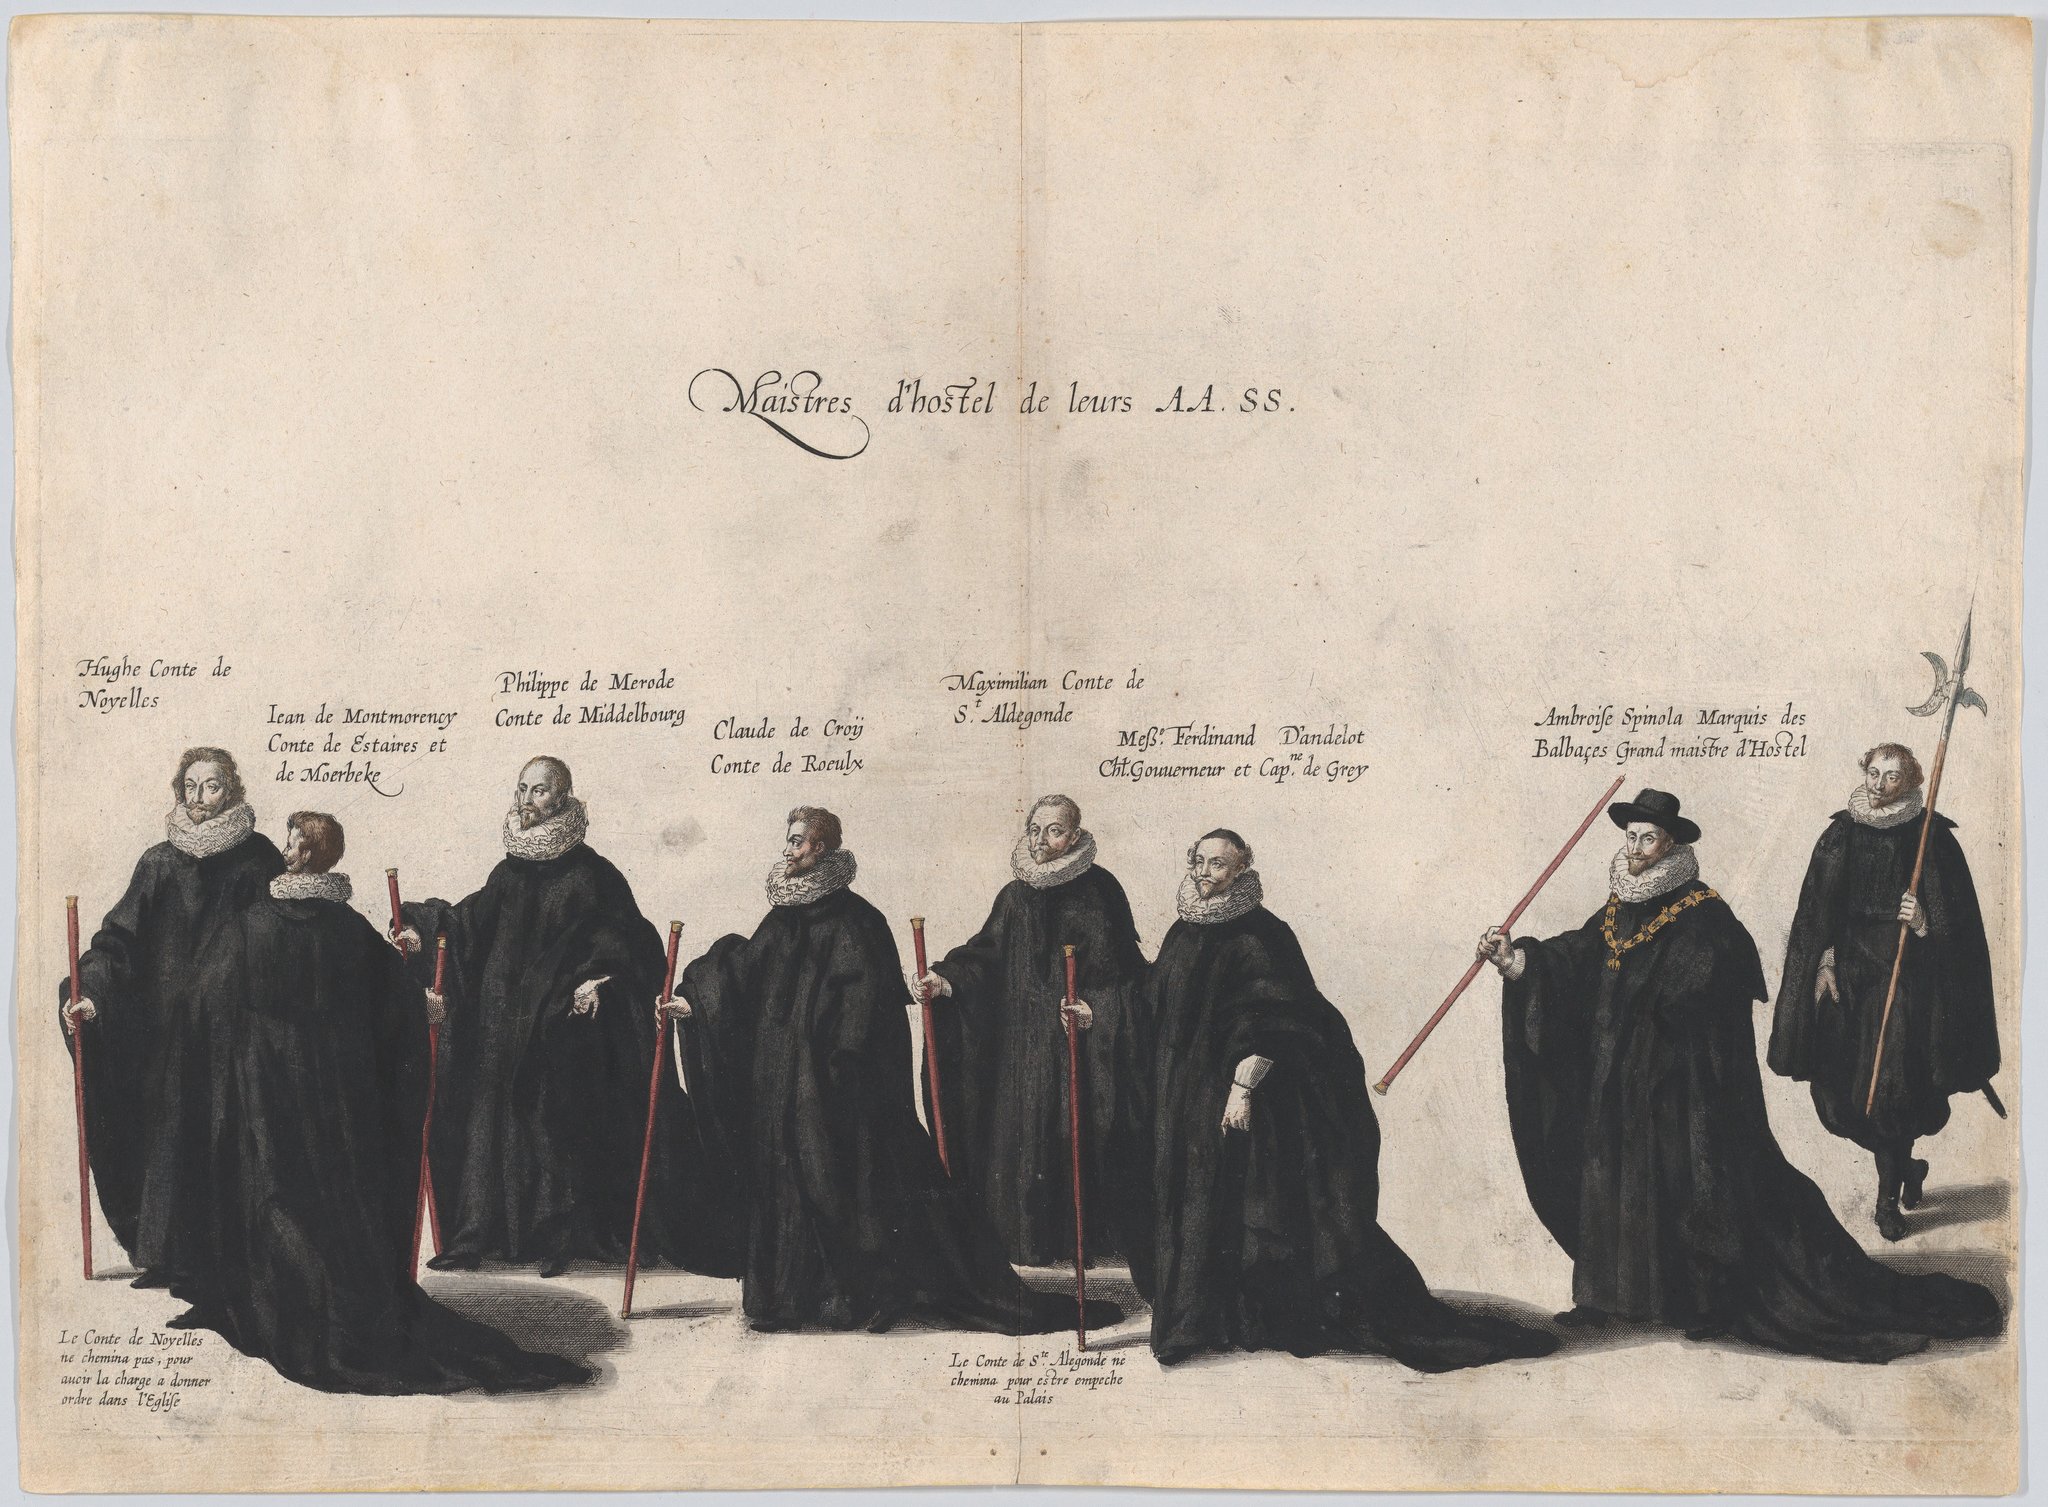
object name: print, fete, ornament architecture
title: Plate 53: Eight figures marching in the funeral procession of Archduke Albert of Austria; from 'Pompa Funebris ... Alberti Pii'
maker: cornelis galle (i)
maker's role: artist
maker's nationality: netherlandish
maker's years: 1576-1650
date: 1623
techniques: etching, hand coloring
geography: brussels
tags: men